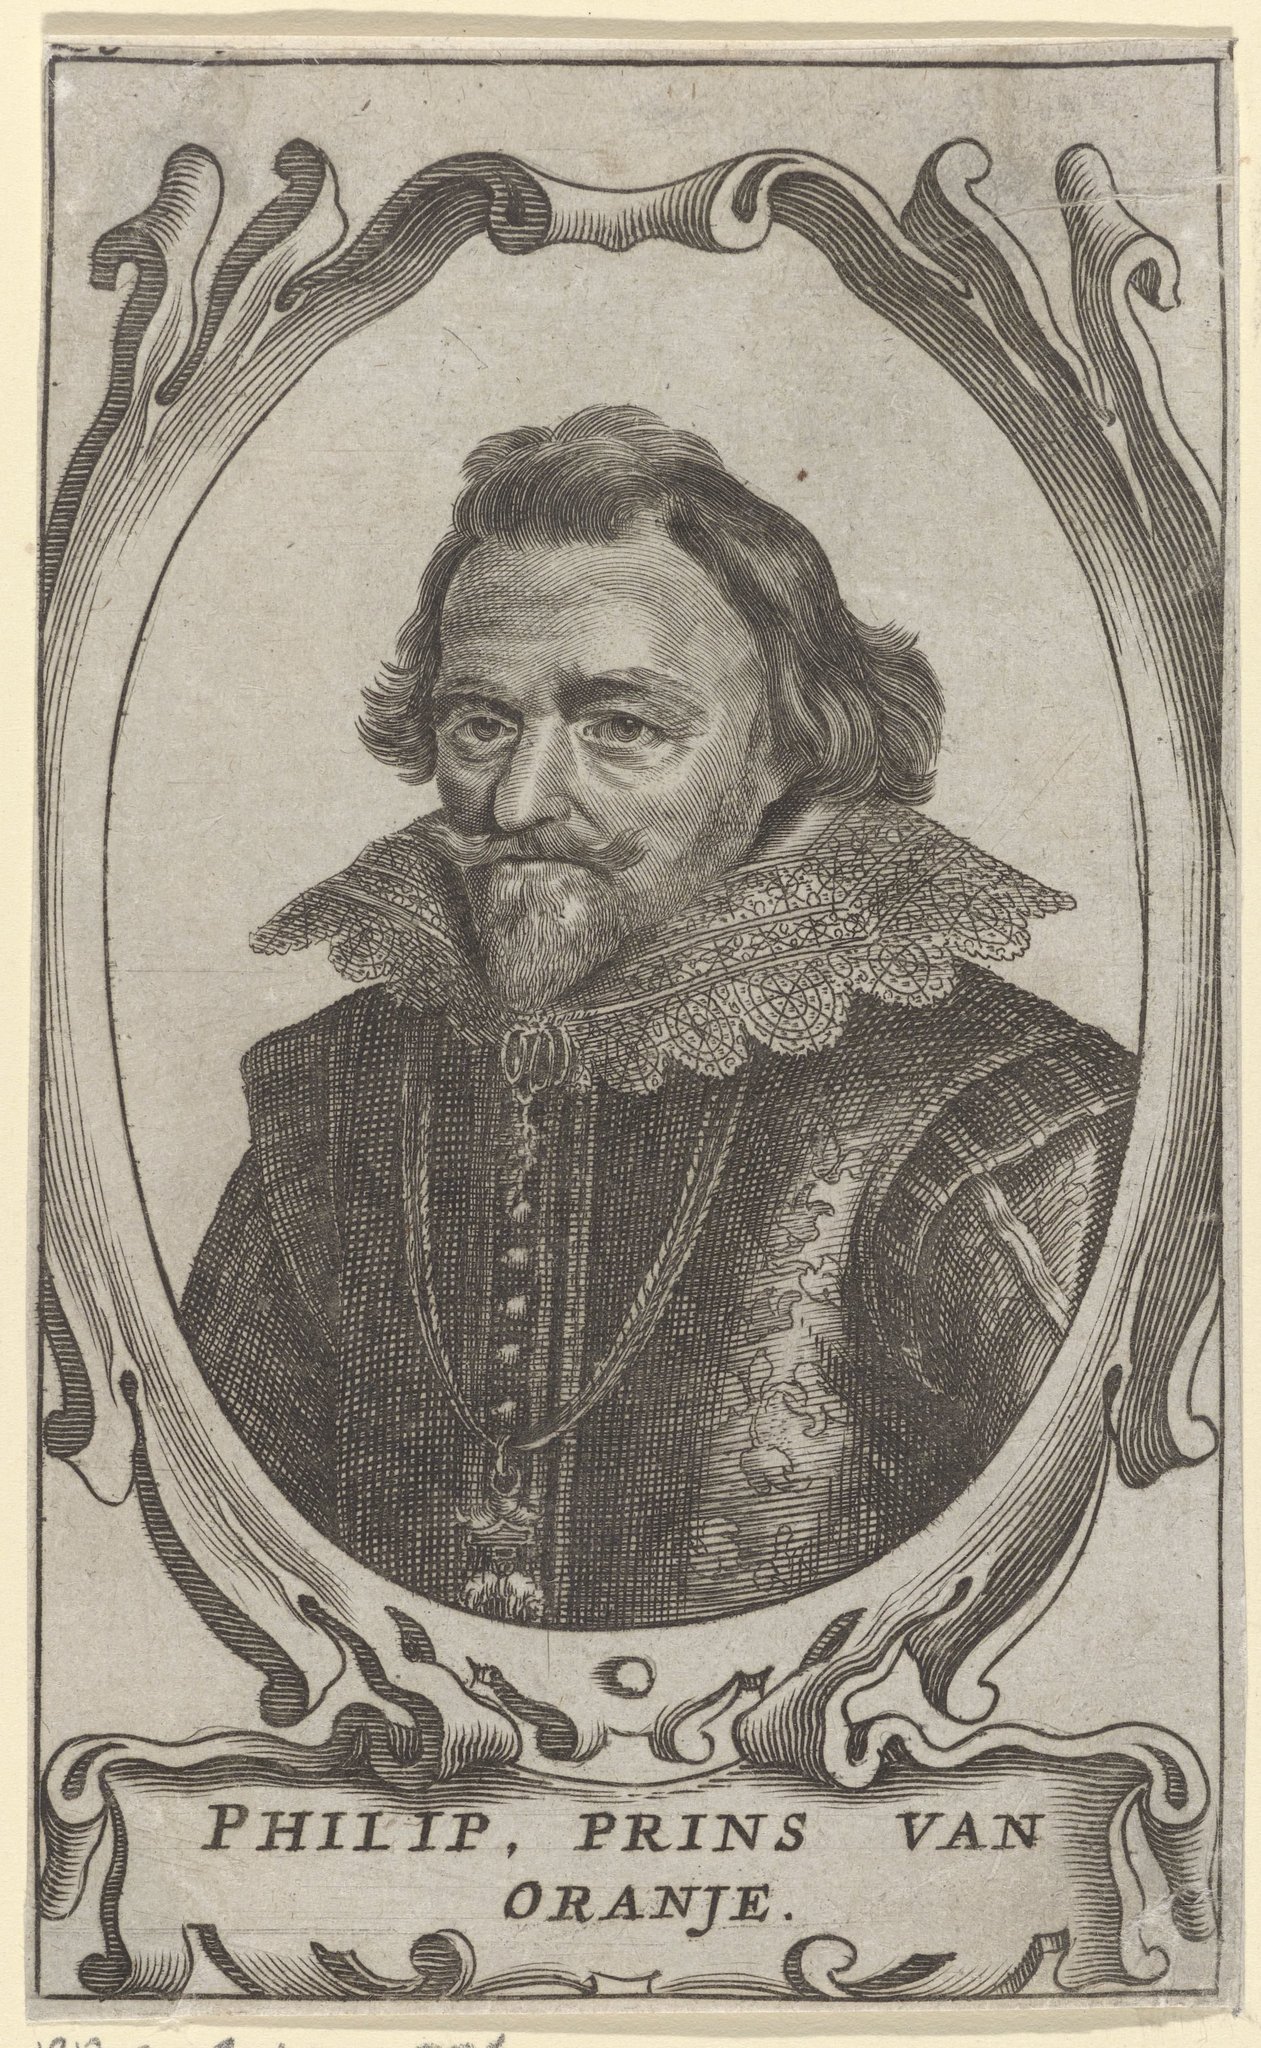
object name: print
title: Portret van Filips Willem, prins van Oranje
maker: Anonymous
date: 1600-1699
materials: paper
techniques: engraving, etching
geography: low countries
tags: filips willem (prins van oranje), knighthood order of the golden fleece - insignia of a knighthood order, e.g.: badge, chain (with name of order)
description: De hier vermelde titel verwijst naar de hoogst verkregen titel van de geportretteerde, niet per se naar de titel die de geportretteerde op deze voorstelling draagt.